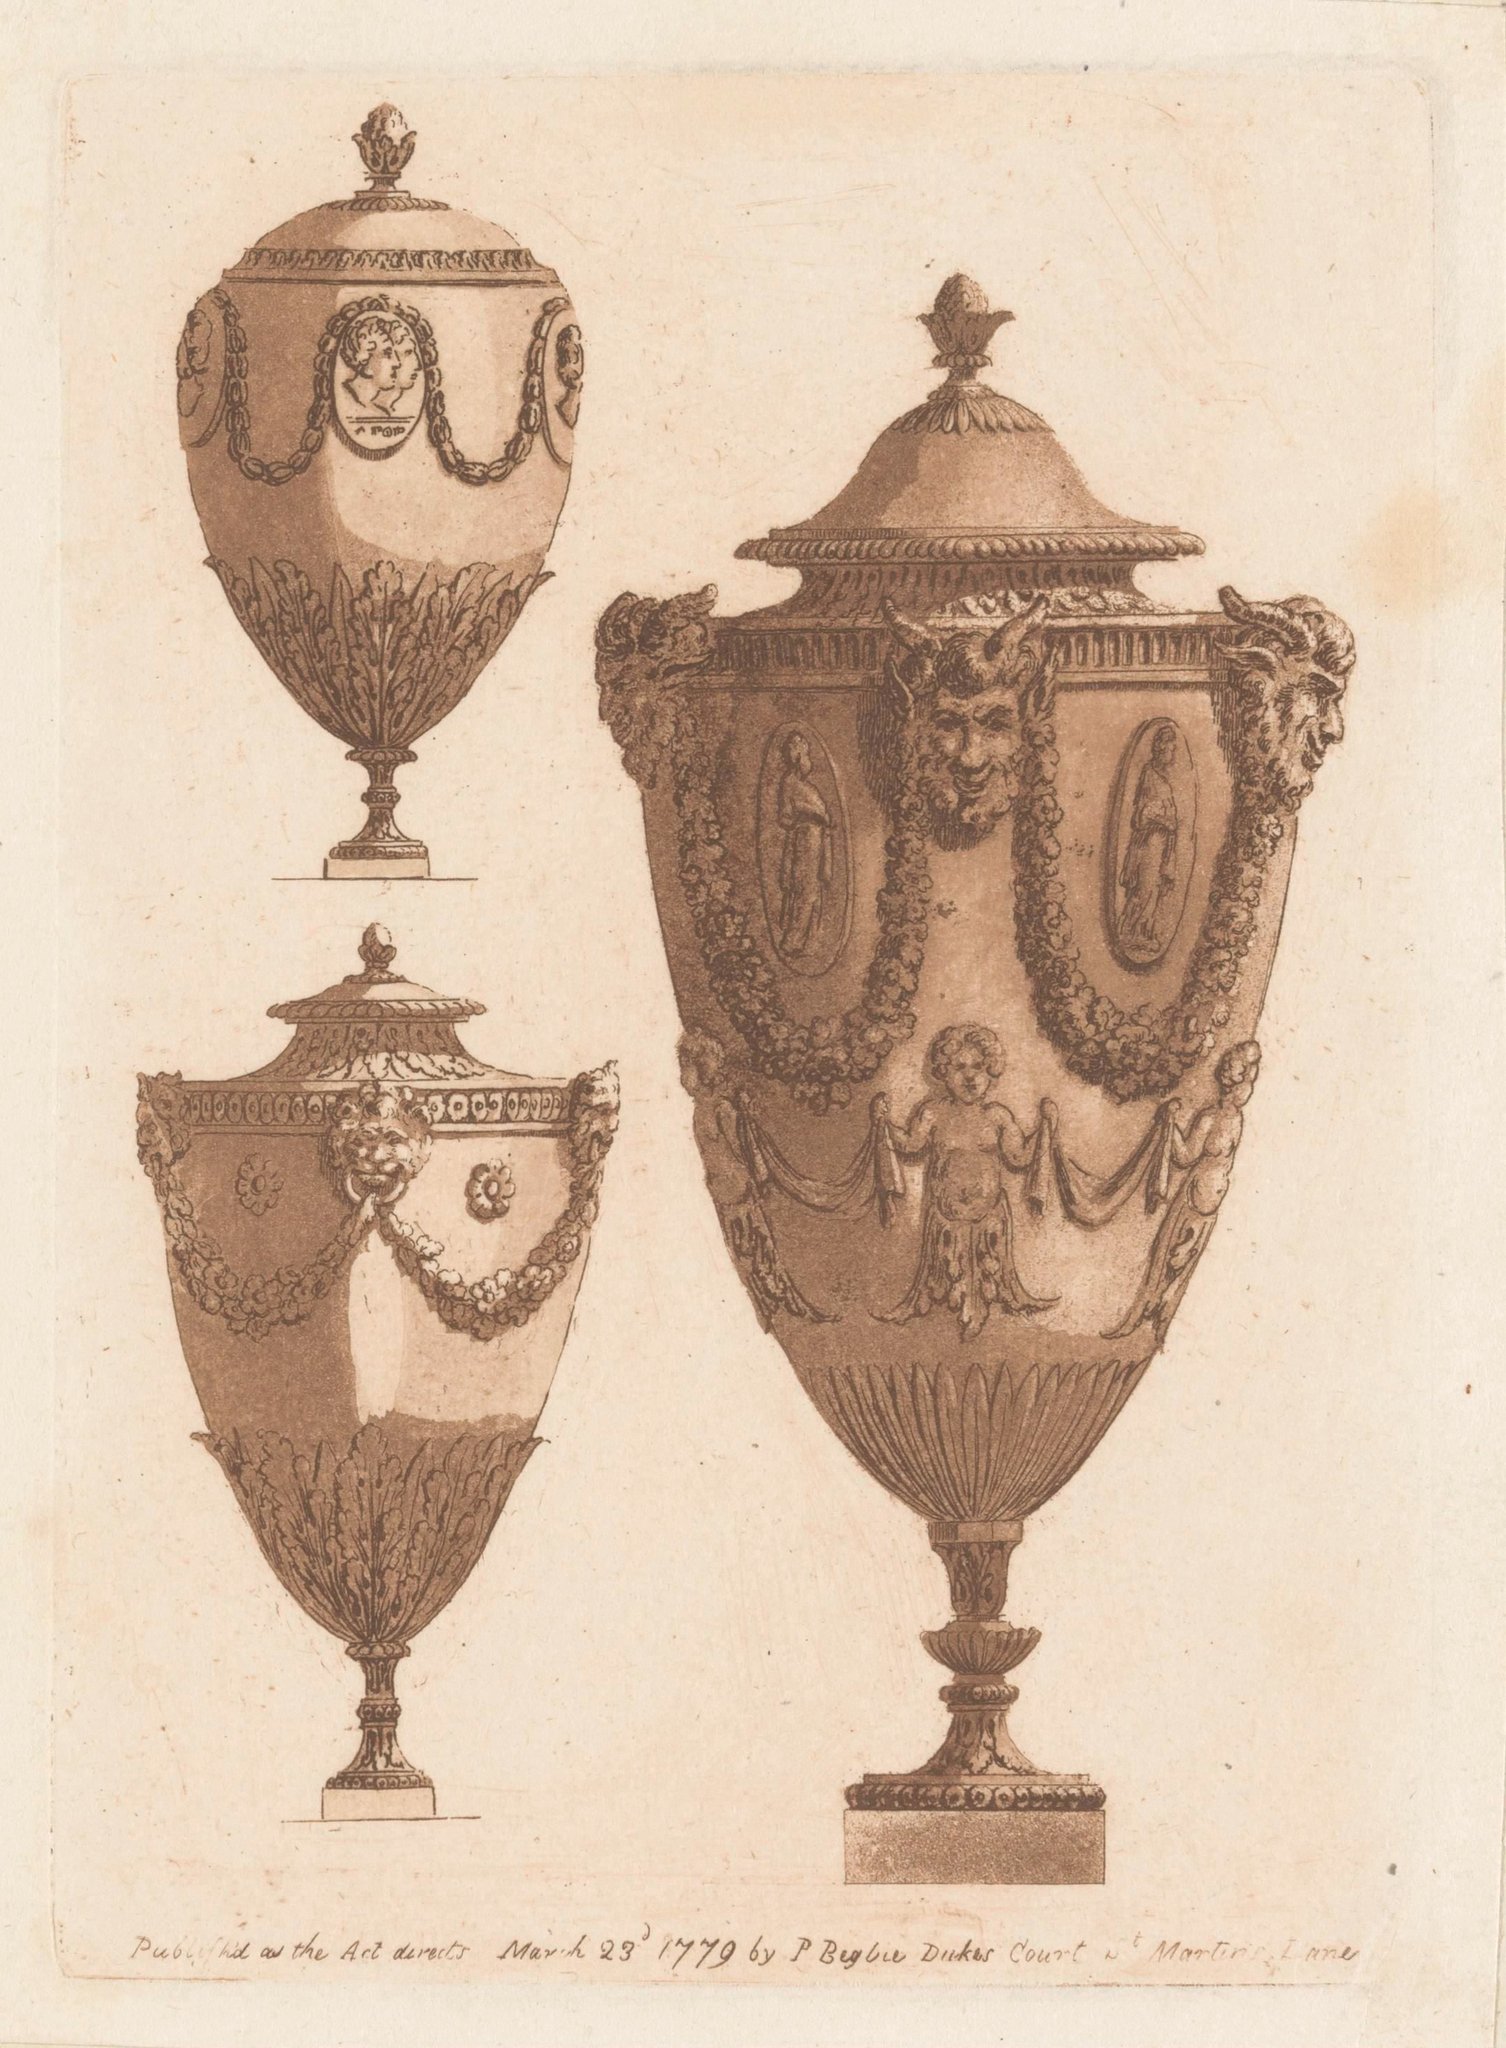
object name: print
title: Drie antieke vazen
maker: patrick begbie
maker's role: print maker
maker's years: -1820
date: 1779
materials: paper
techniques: aquatint, etching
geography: london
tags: ornament ~ medallion, vase ~ ornament, satyr(s) (in general), ornament ~ festoon, garland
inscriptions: collector's mark: Lugt 2228, collector's mark: Lugt 2760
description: Drie antieke geornamenteerde vazen met guirlandes en medaillons. De grootste vaas rechts met satyrkoppen langs de rand.